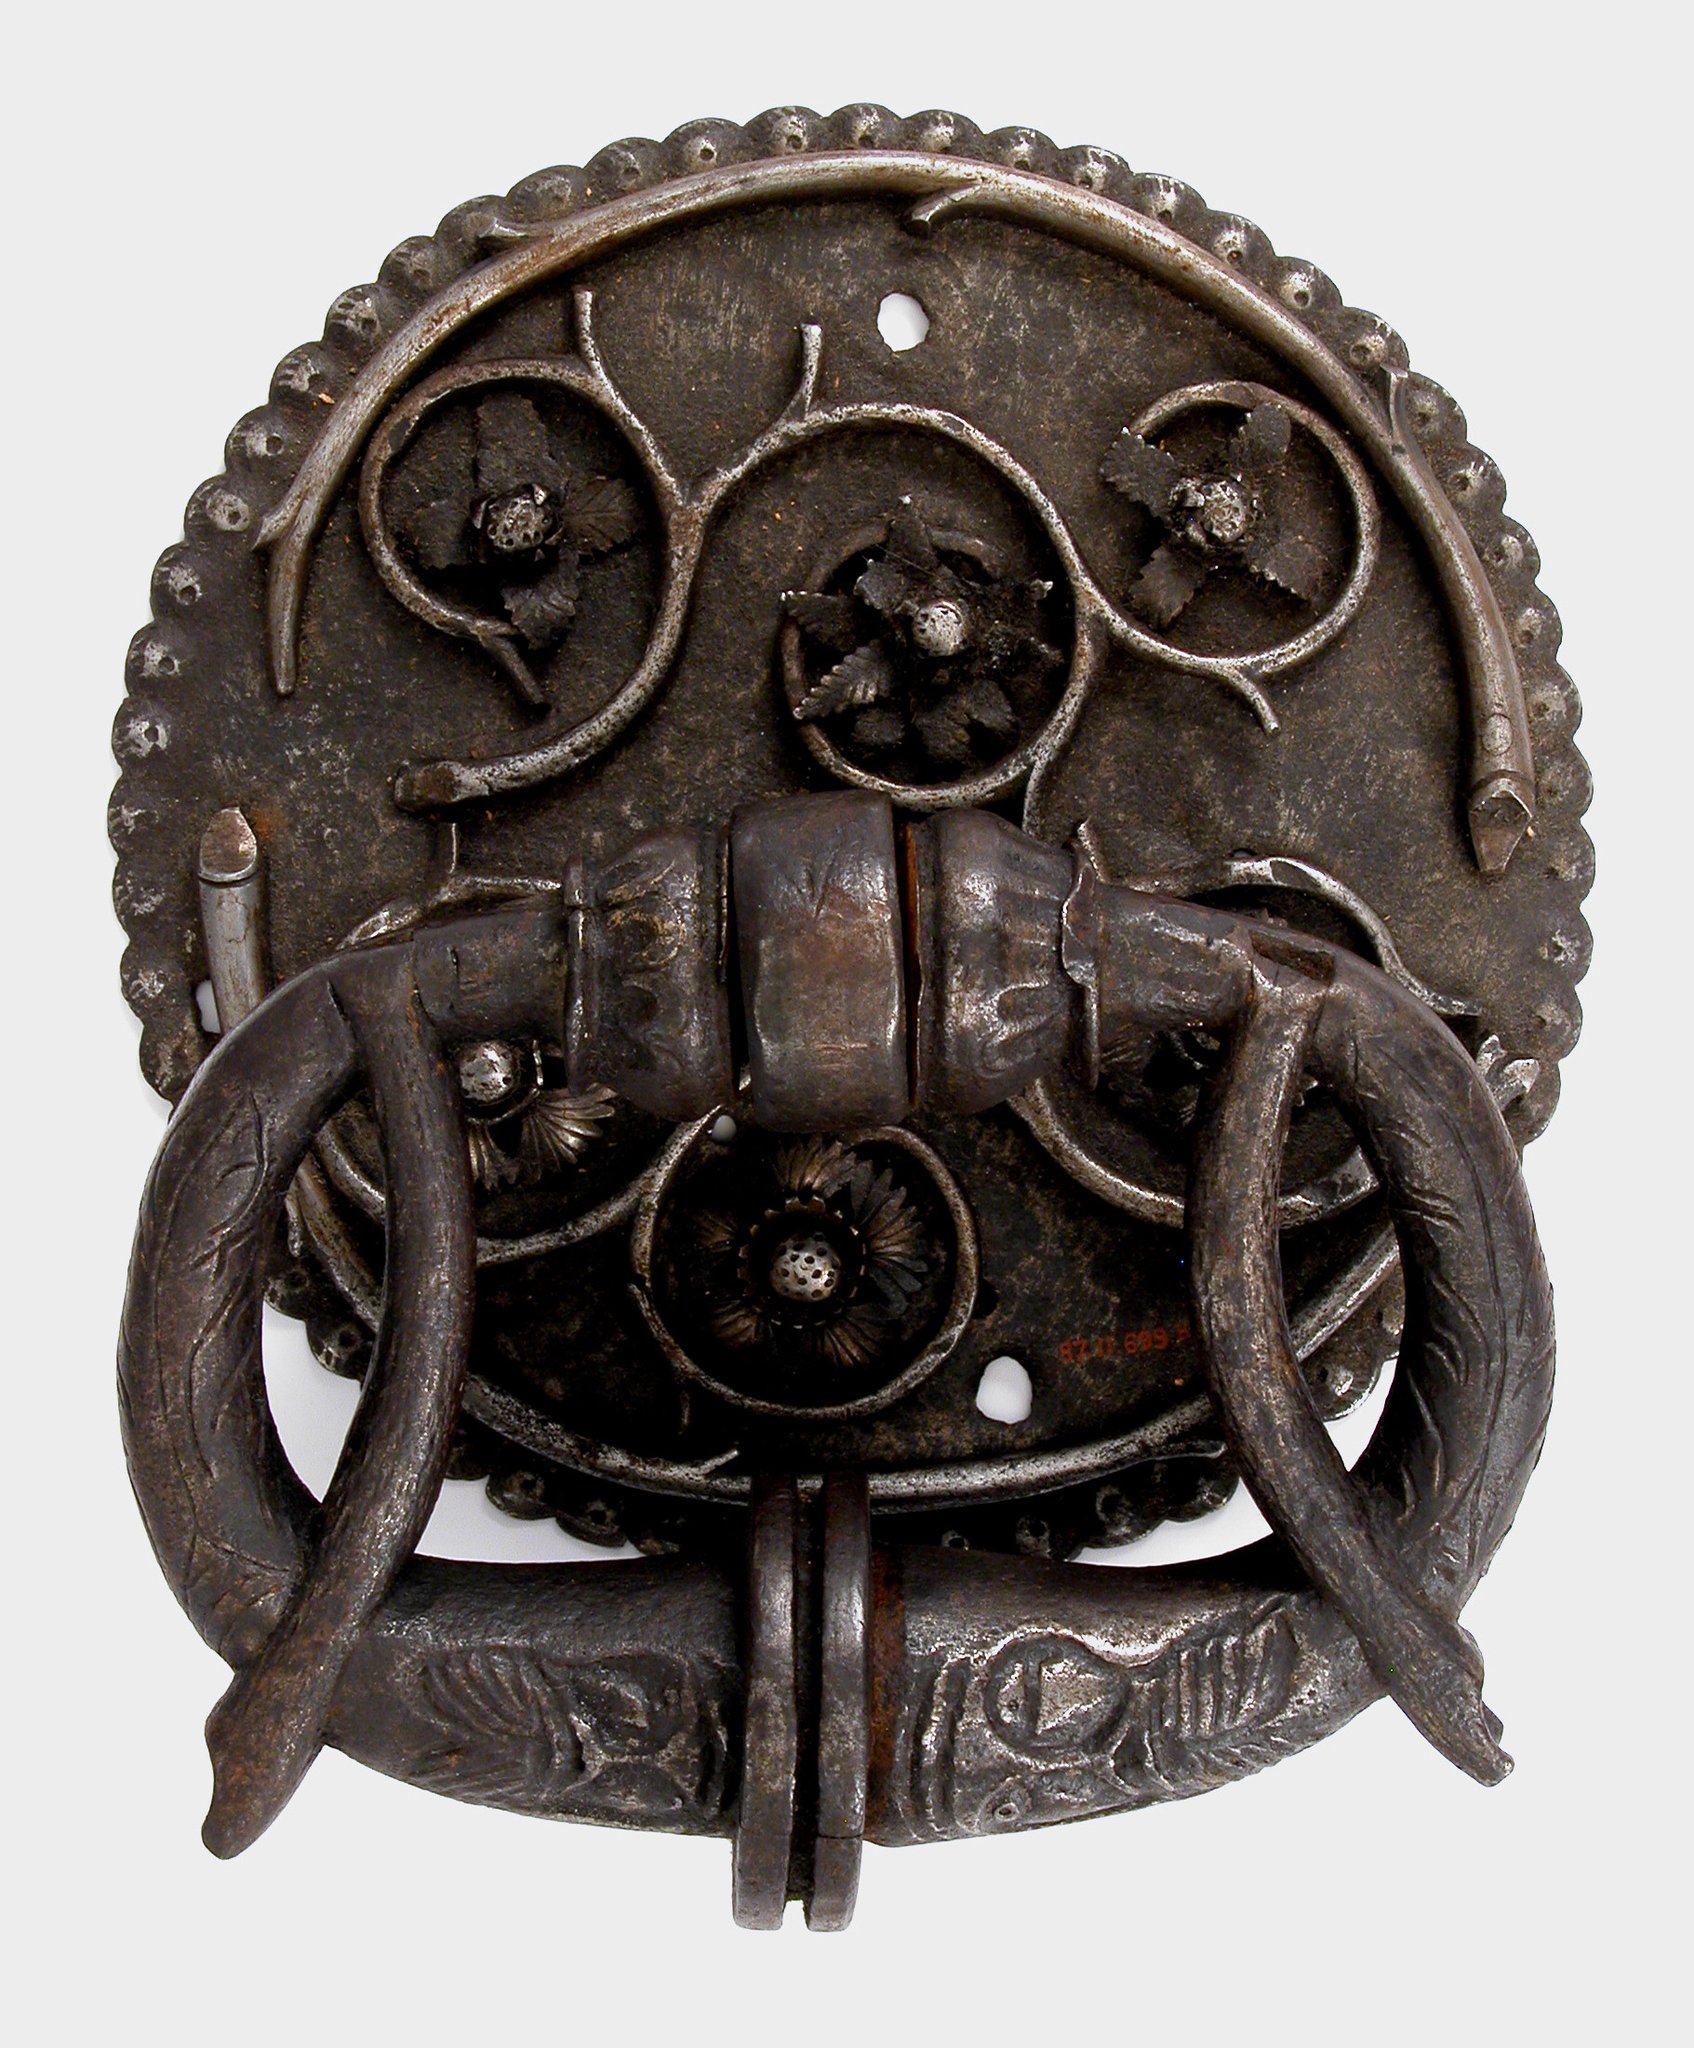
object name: door handle or knocker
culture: german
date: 1401-1600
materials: iron